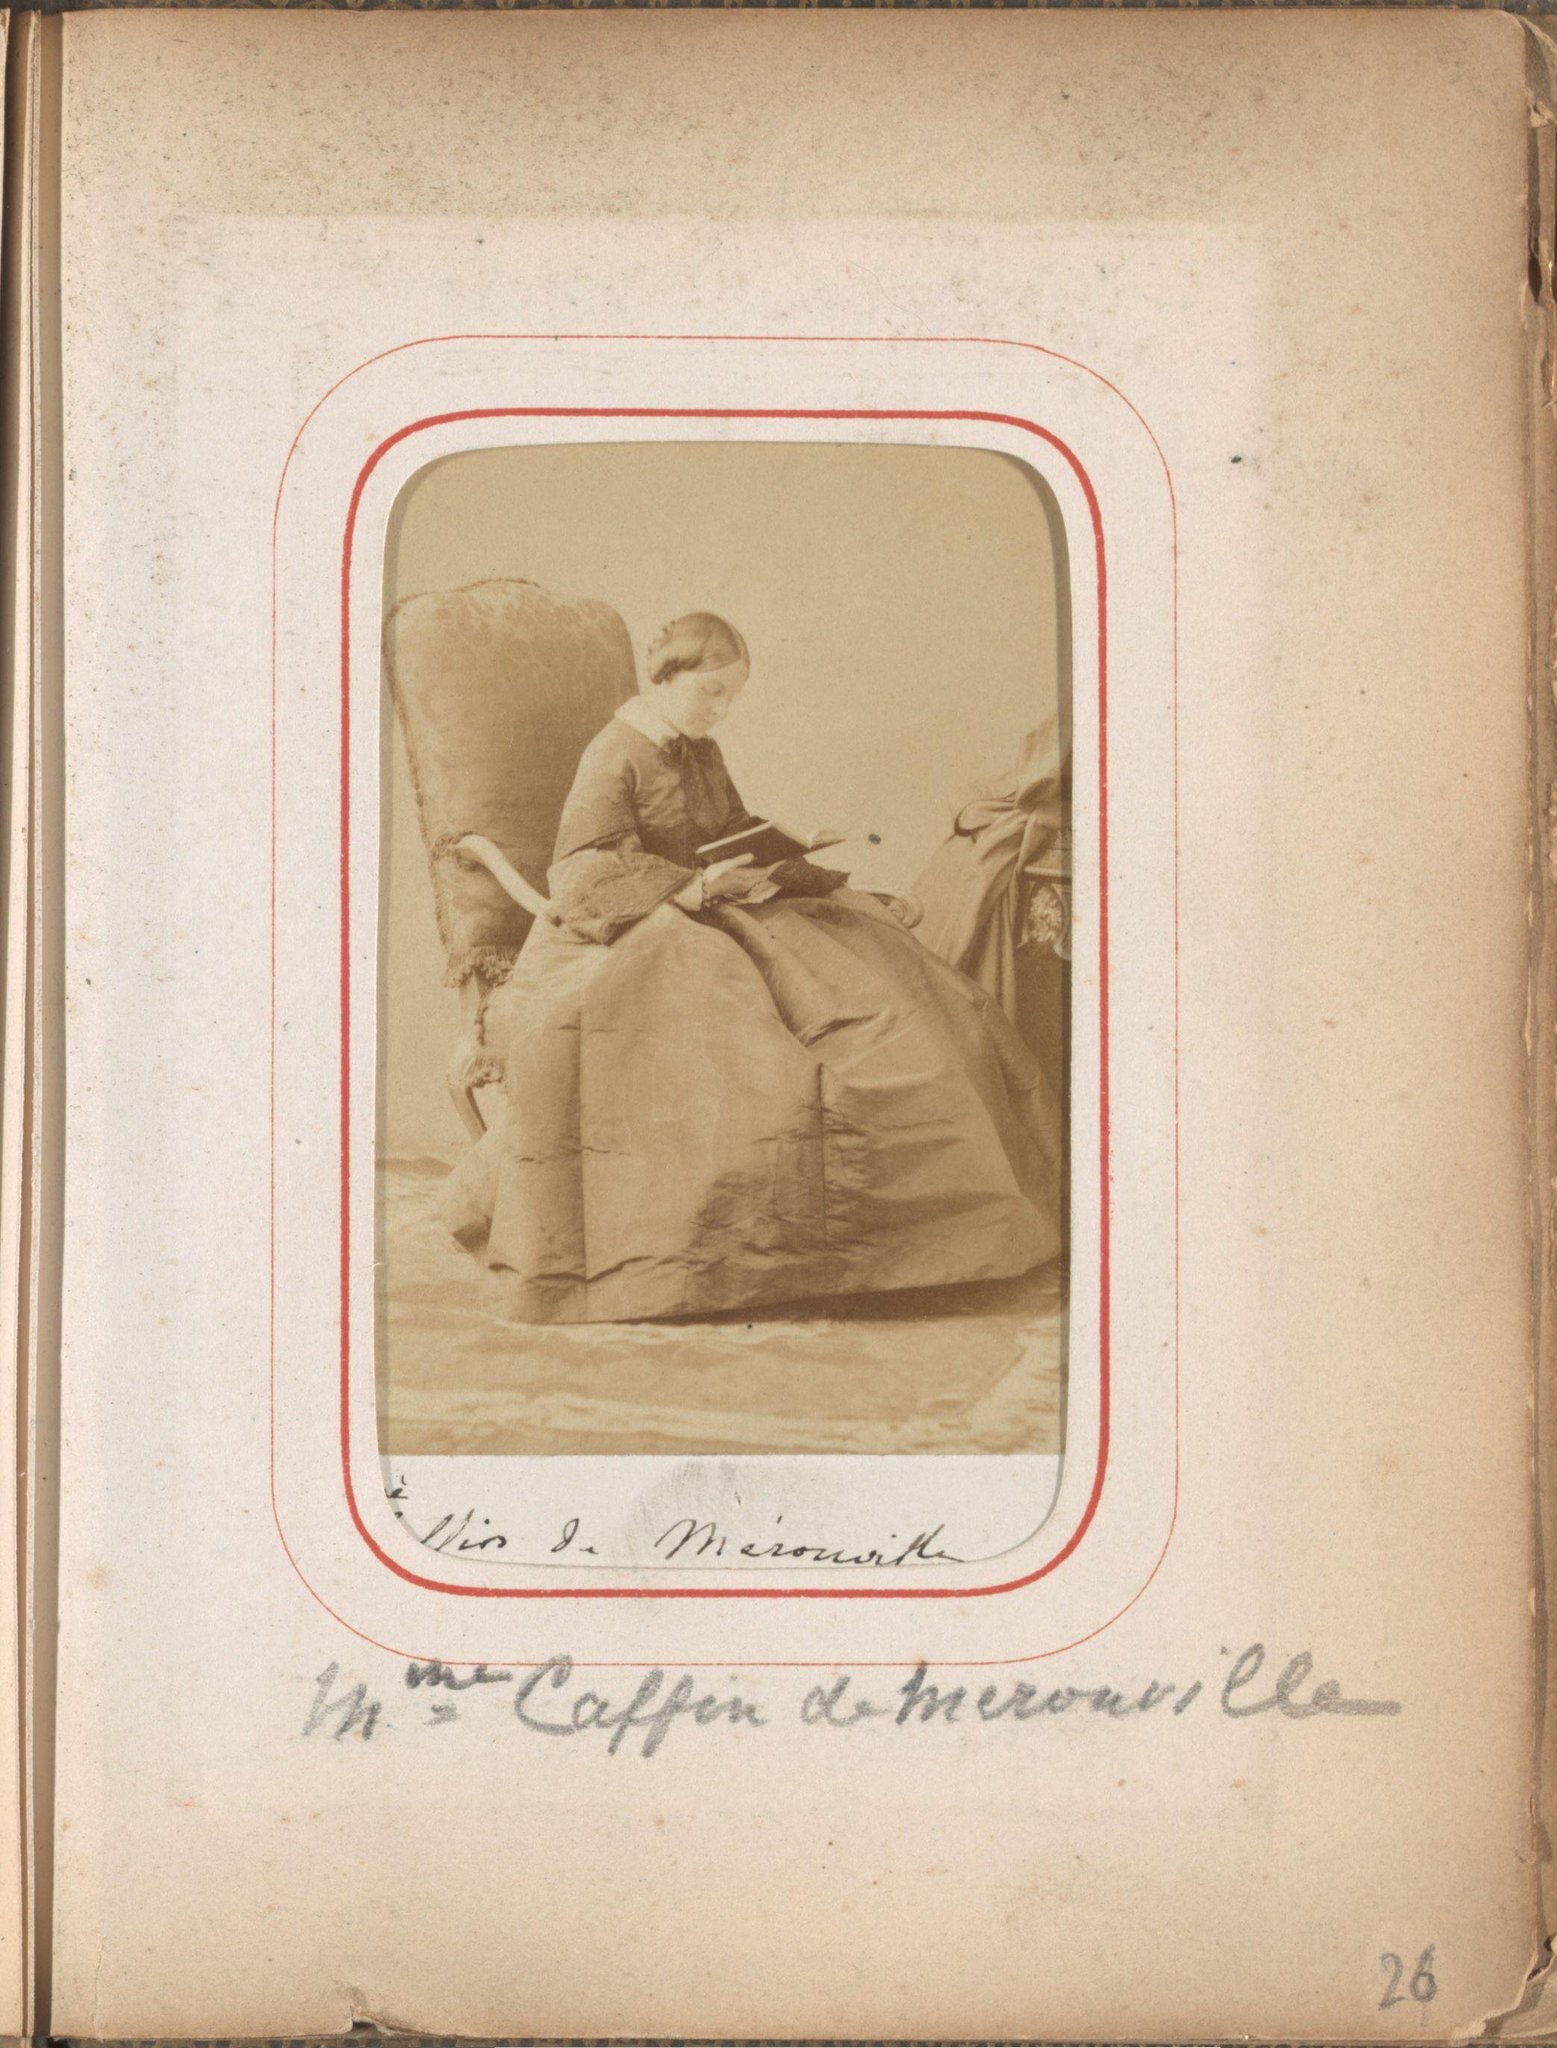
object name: carte de visite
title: Mme Caffin de Meronville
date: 1860-1865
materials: cardboard, paper, photographic support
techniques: albumen print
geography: paris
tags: reading, studio requisites ~ photographer, historical persons, styles of hairdress - aa - ~ women, book, dress, gown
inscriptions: address: ‘8, Boulevart des Italiens’, name: ‘M.me Caffin de Meronville’